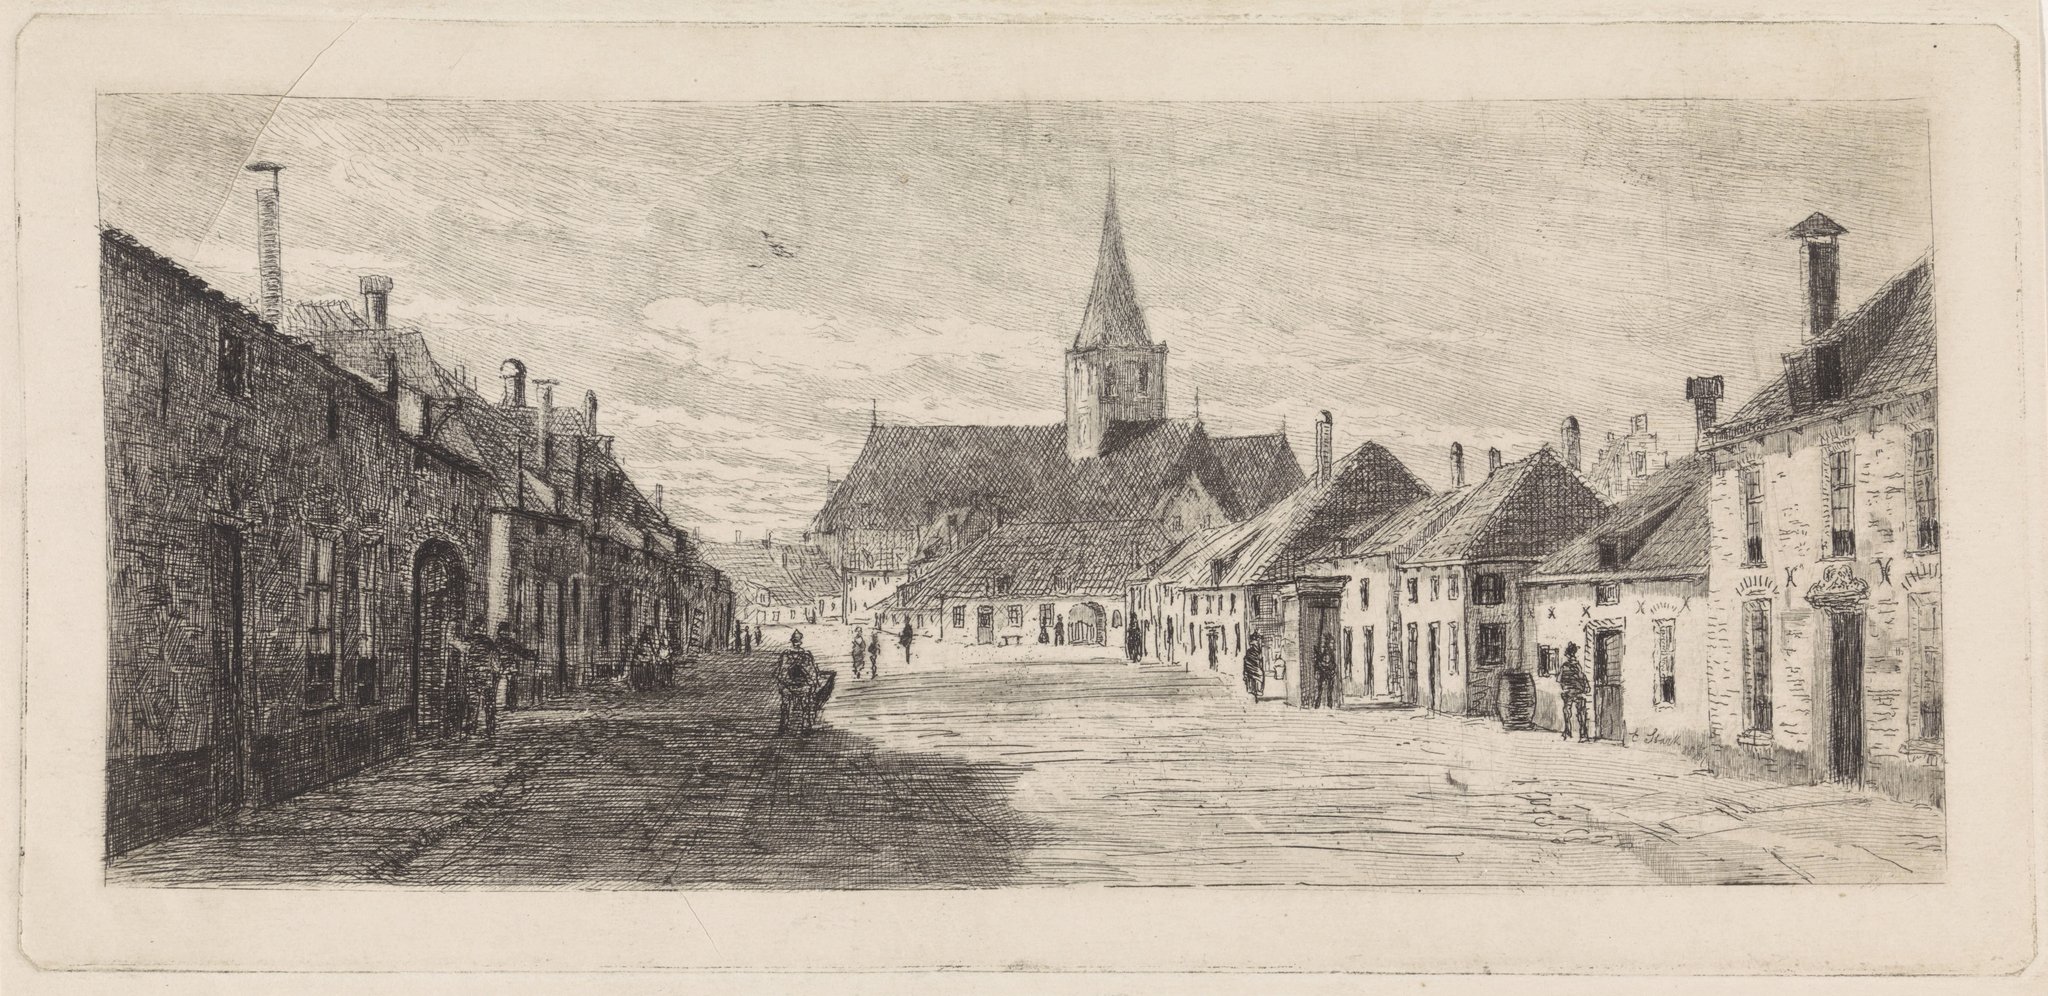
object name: print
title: Straat in Amersfoort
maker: elias stark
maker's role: draughtsman, print maker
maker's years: 1849-1933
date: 1887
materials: paper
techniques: drypoint, etching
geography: nieuwer-amstel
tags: village street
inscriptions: collector's mark: Lugt 2228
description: Straat in de stad Amersfoort met aan het einde de Sint-Joriskerk.